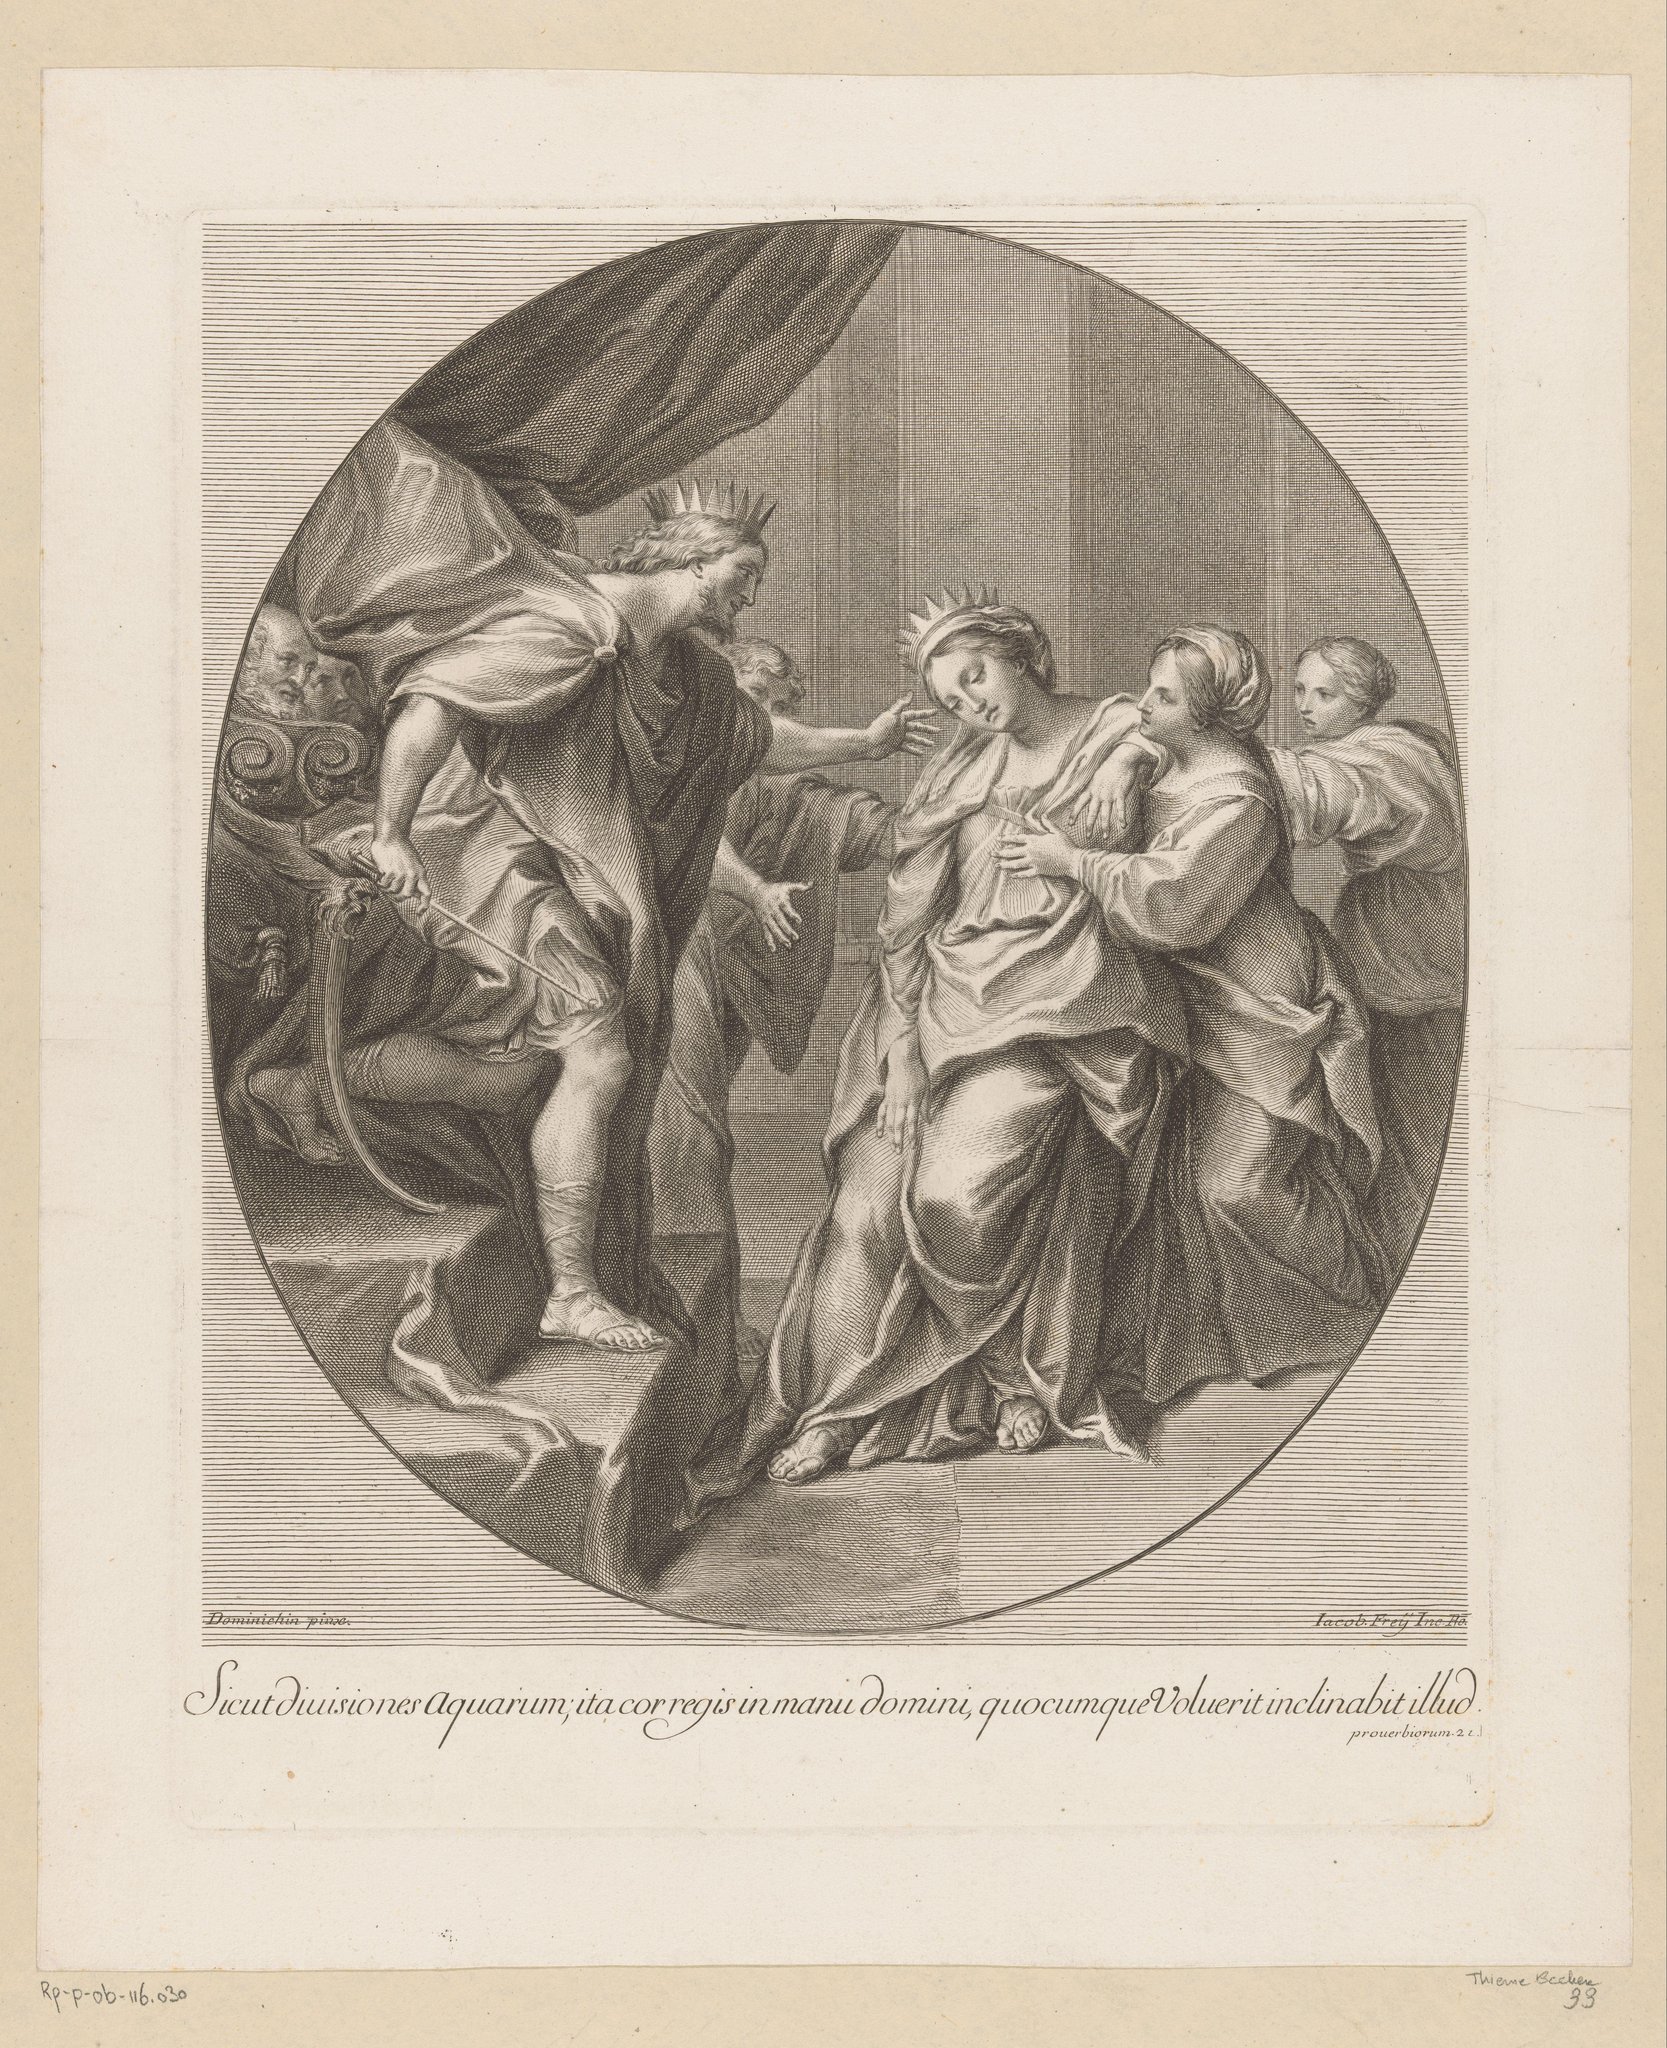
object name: print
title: Esther voor Ahasverus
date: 1718-1719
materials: paper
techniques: engraving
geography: rome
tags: esther before ahasuerus (esther 5:1-4), esther swoons on the shoulder of one of her maids (esther 15:7)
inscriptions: collector's mark: Lugt 240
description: Naar één van de vier tondo's door Domenichino in de San Silvestro al Quirinale in Rome.